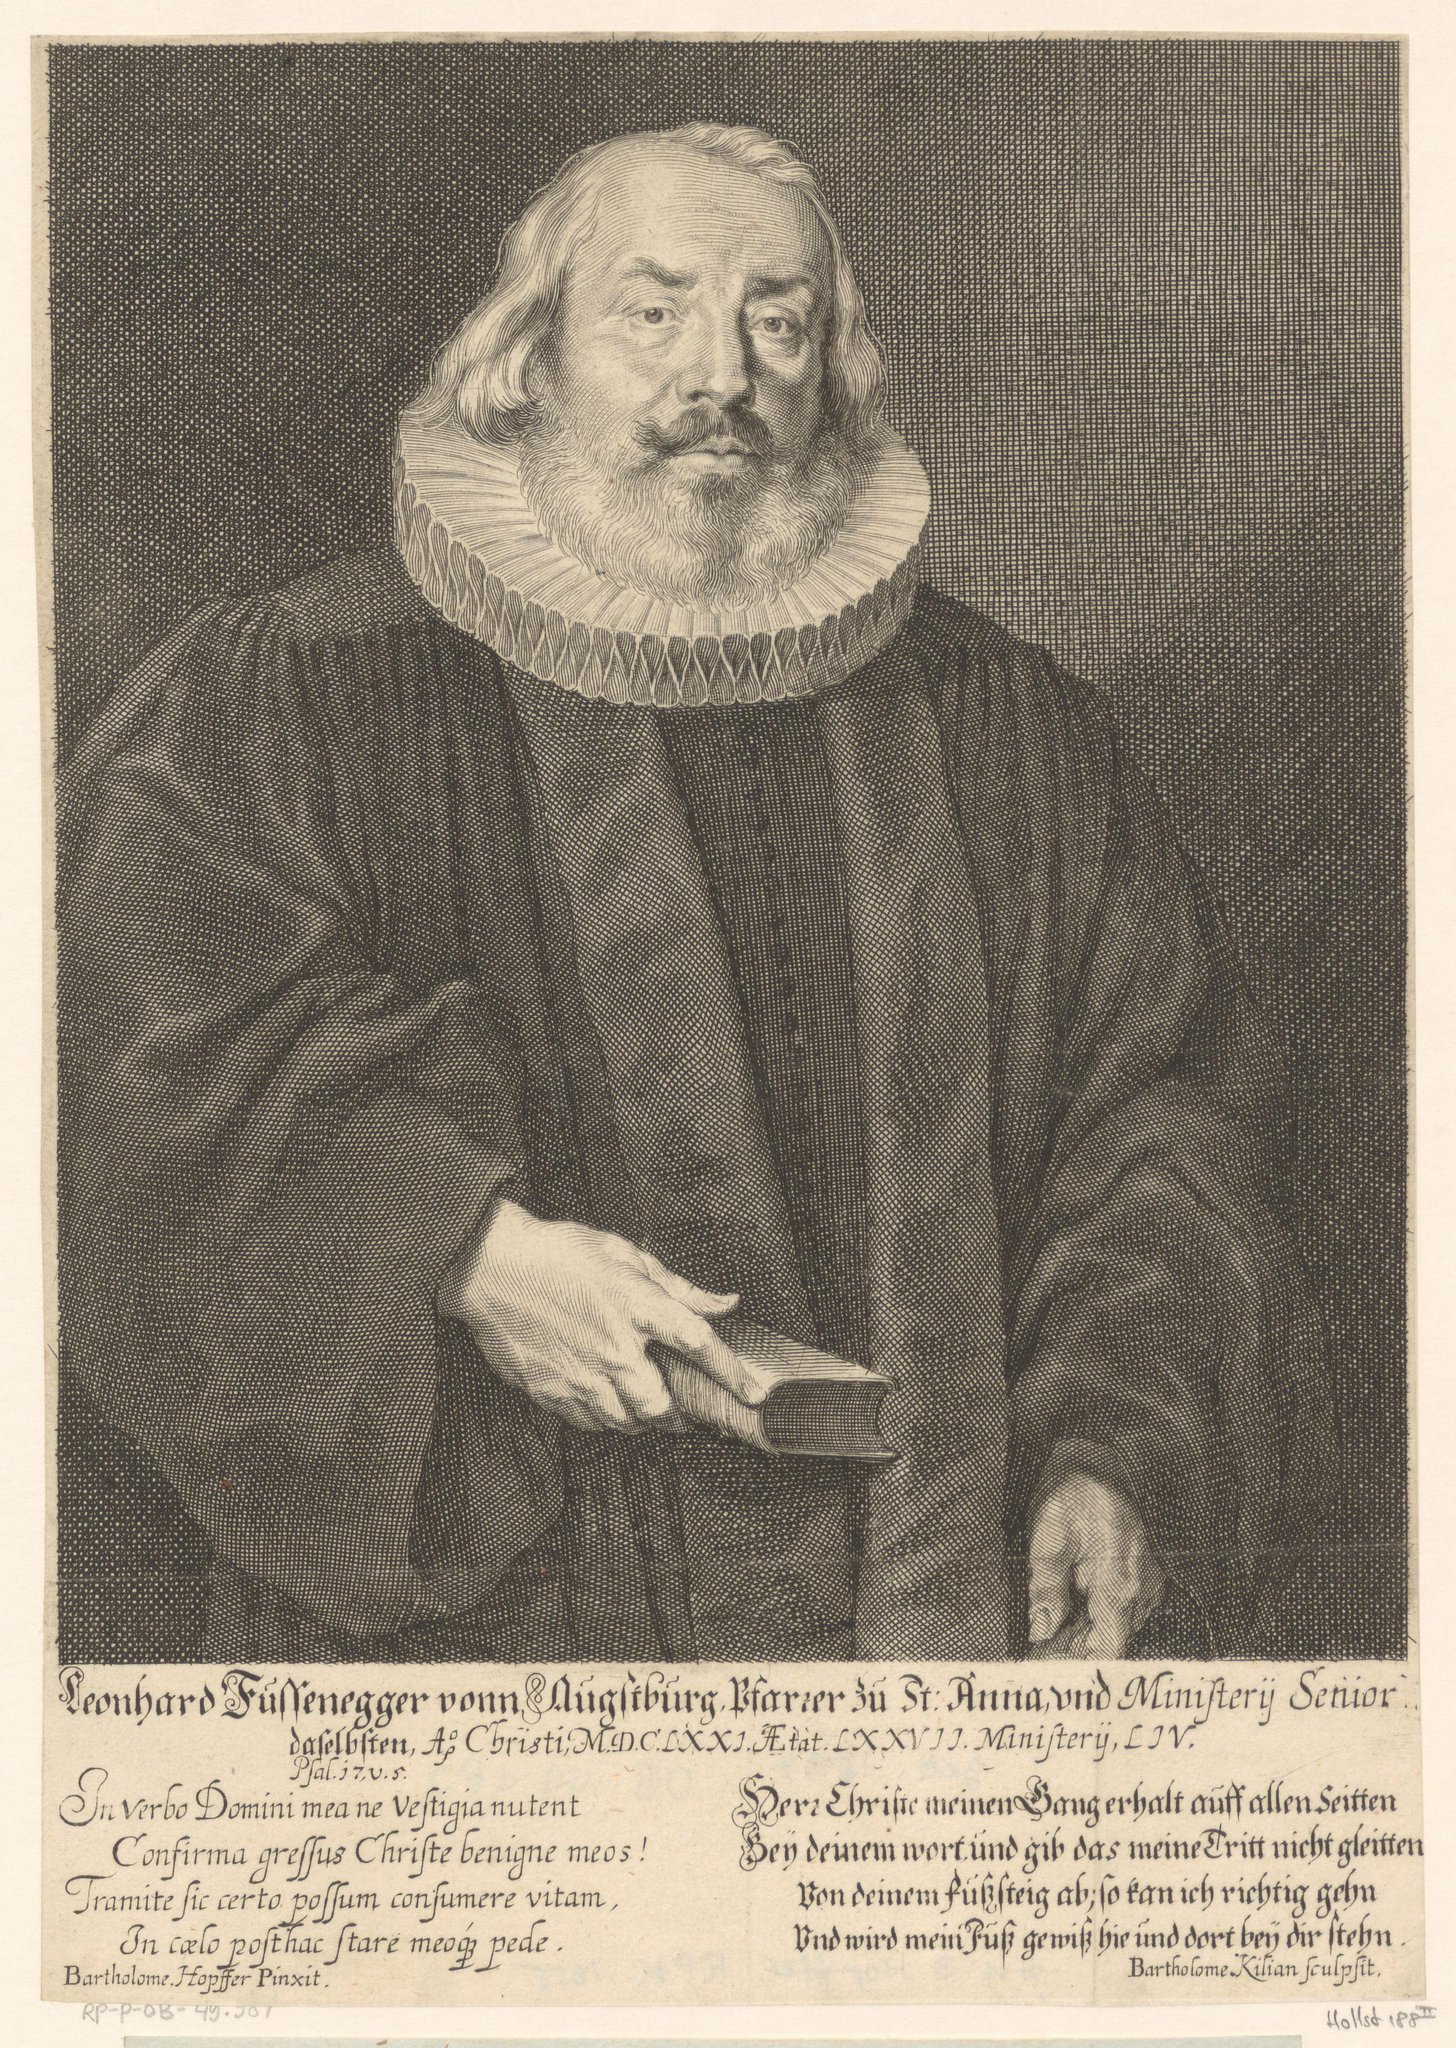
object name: print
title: Portret van Leonhard Fussenegger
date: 1671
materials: paper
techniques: engraving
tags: theologian, historical persons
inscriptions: collector's mark: Lugt 2228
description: Tekst in Latijn met informatie over geportretteerde en in de marge onderaan Psalm 17:5 in het Latijn en Duits